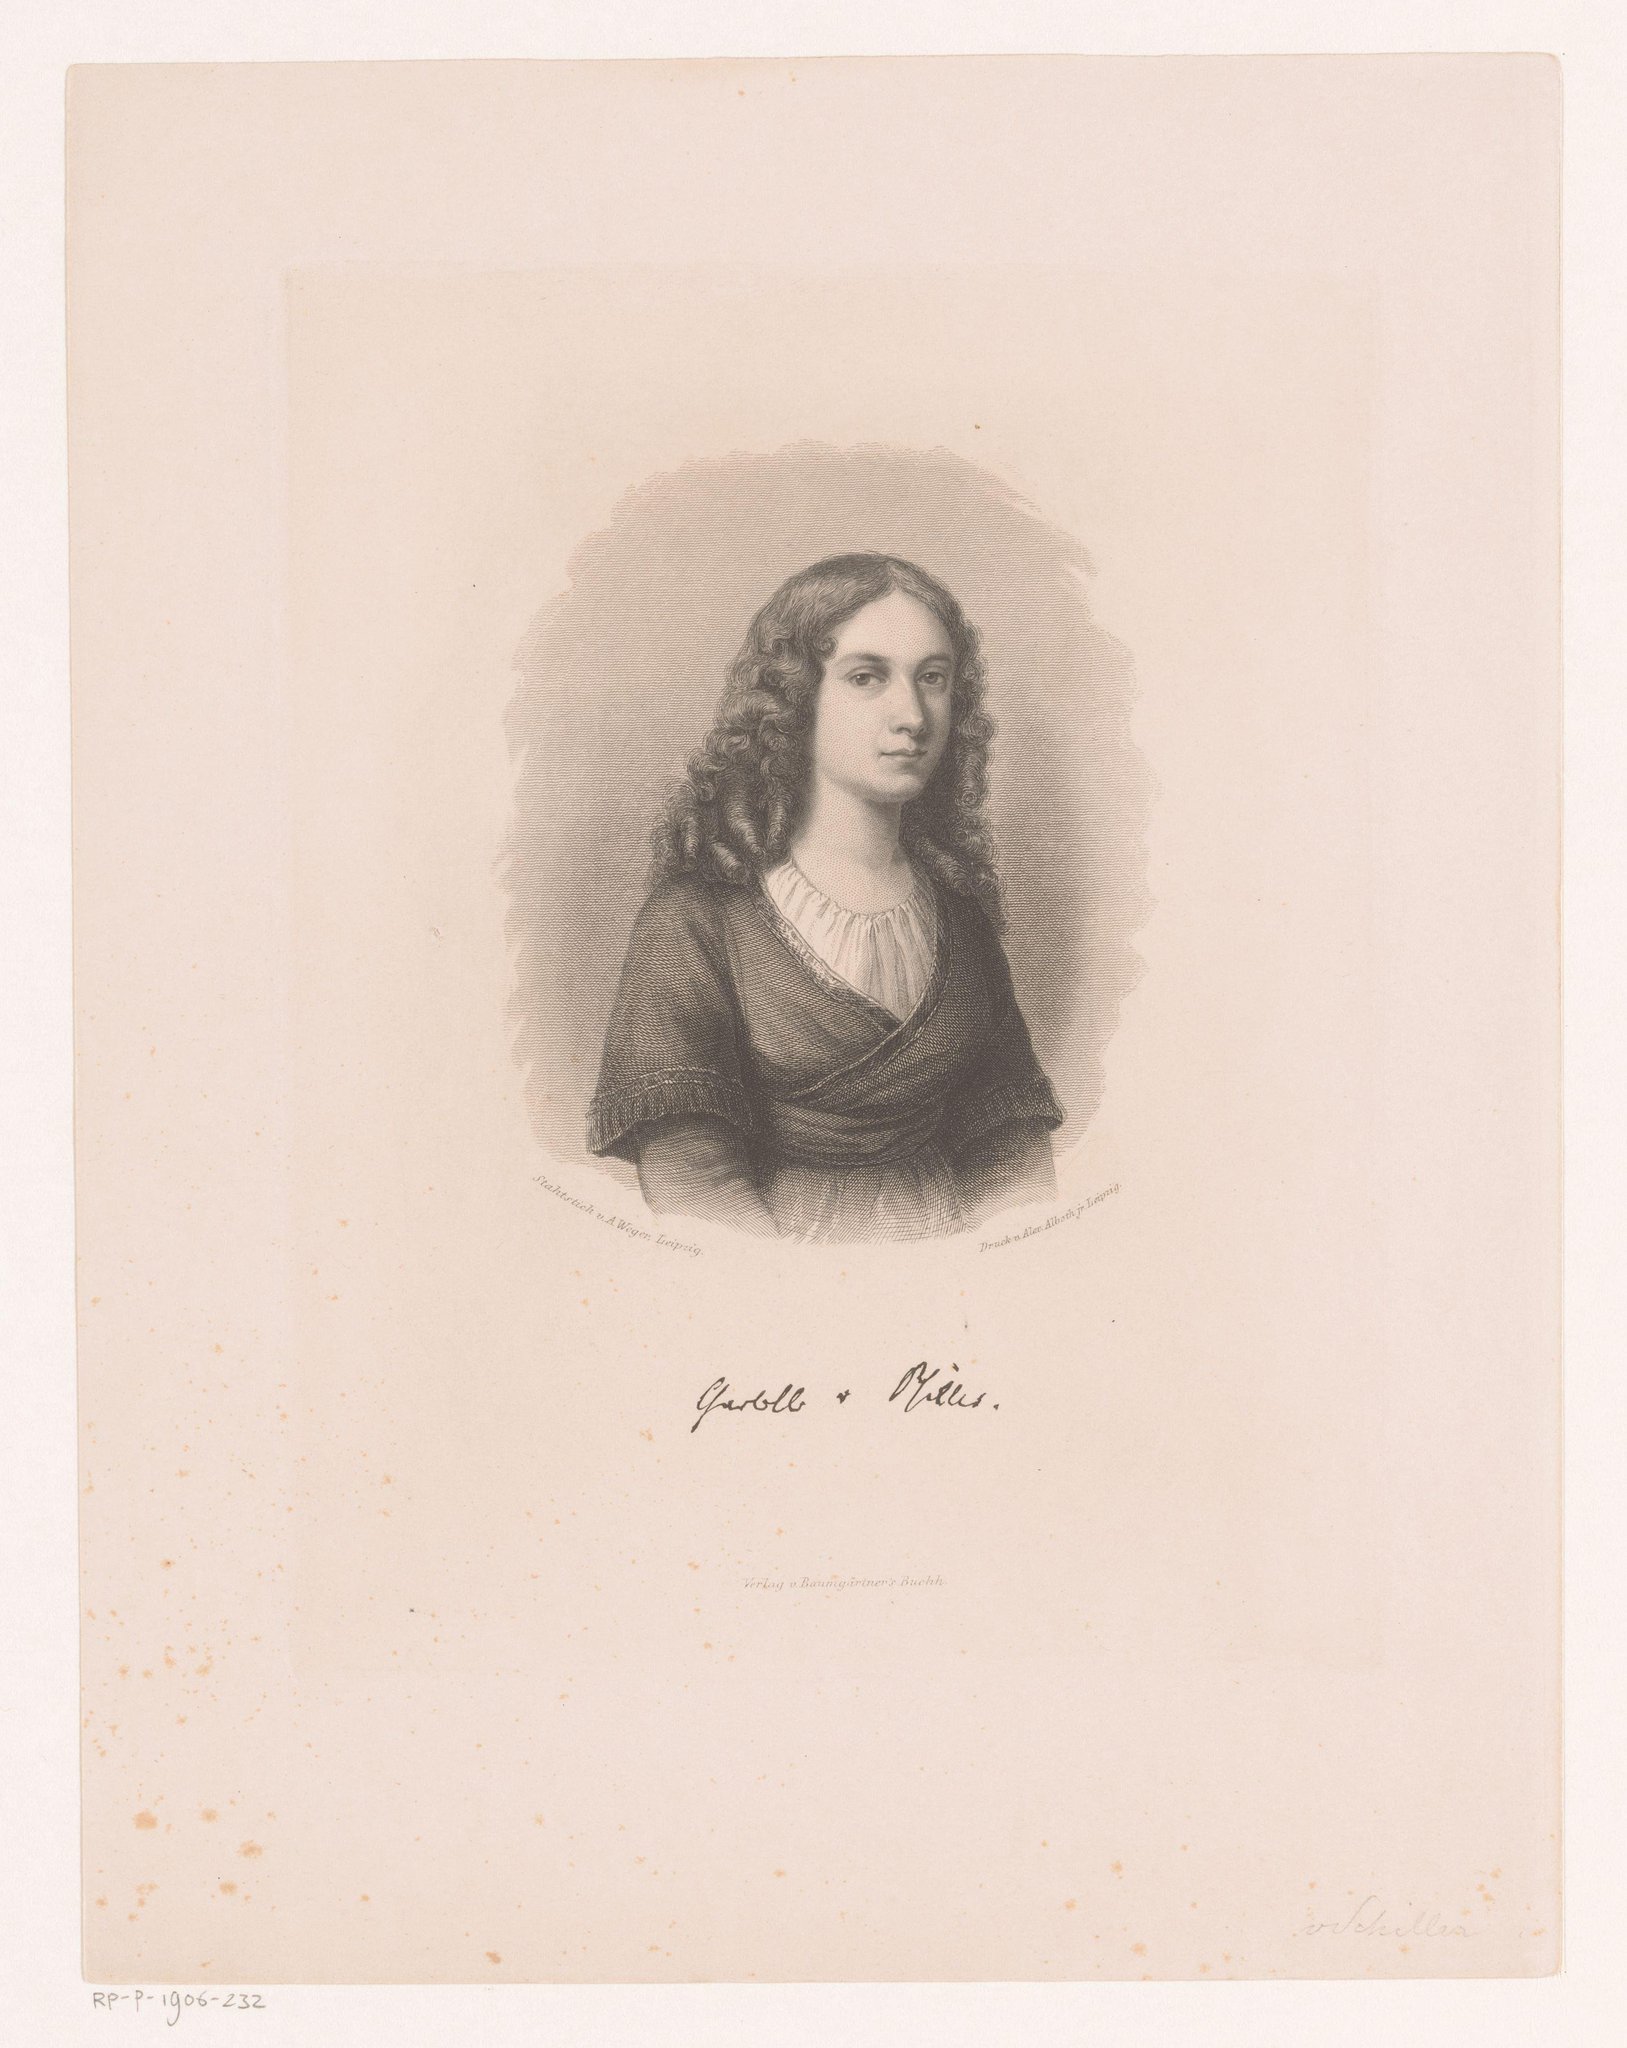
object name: print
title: Portret van Charlotte Schiller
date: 1849-1892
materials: paper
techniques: engraving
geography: leipzig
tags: historical persons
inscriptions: collector's mark: Lugt 2228